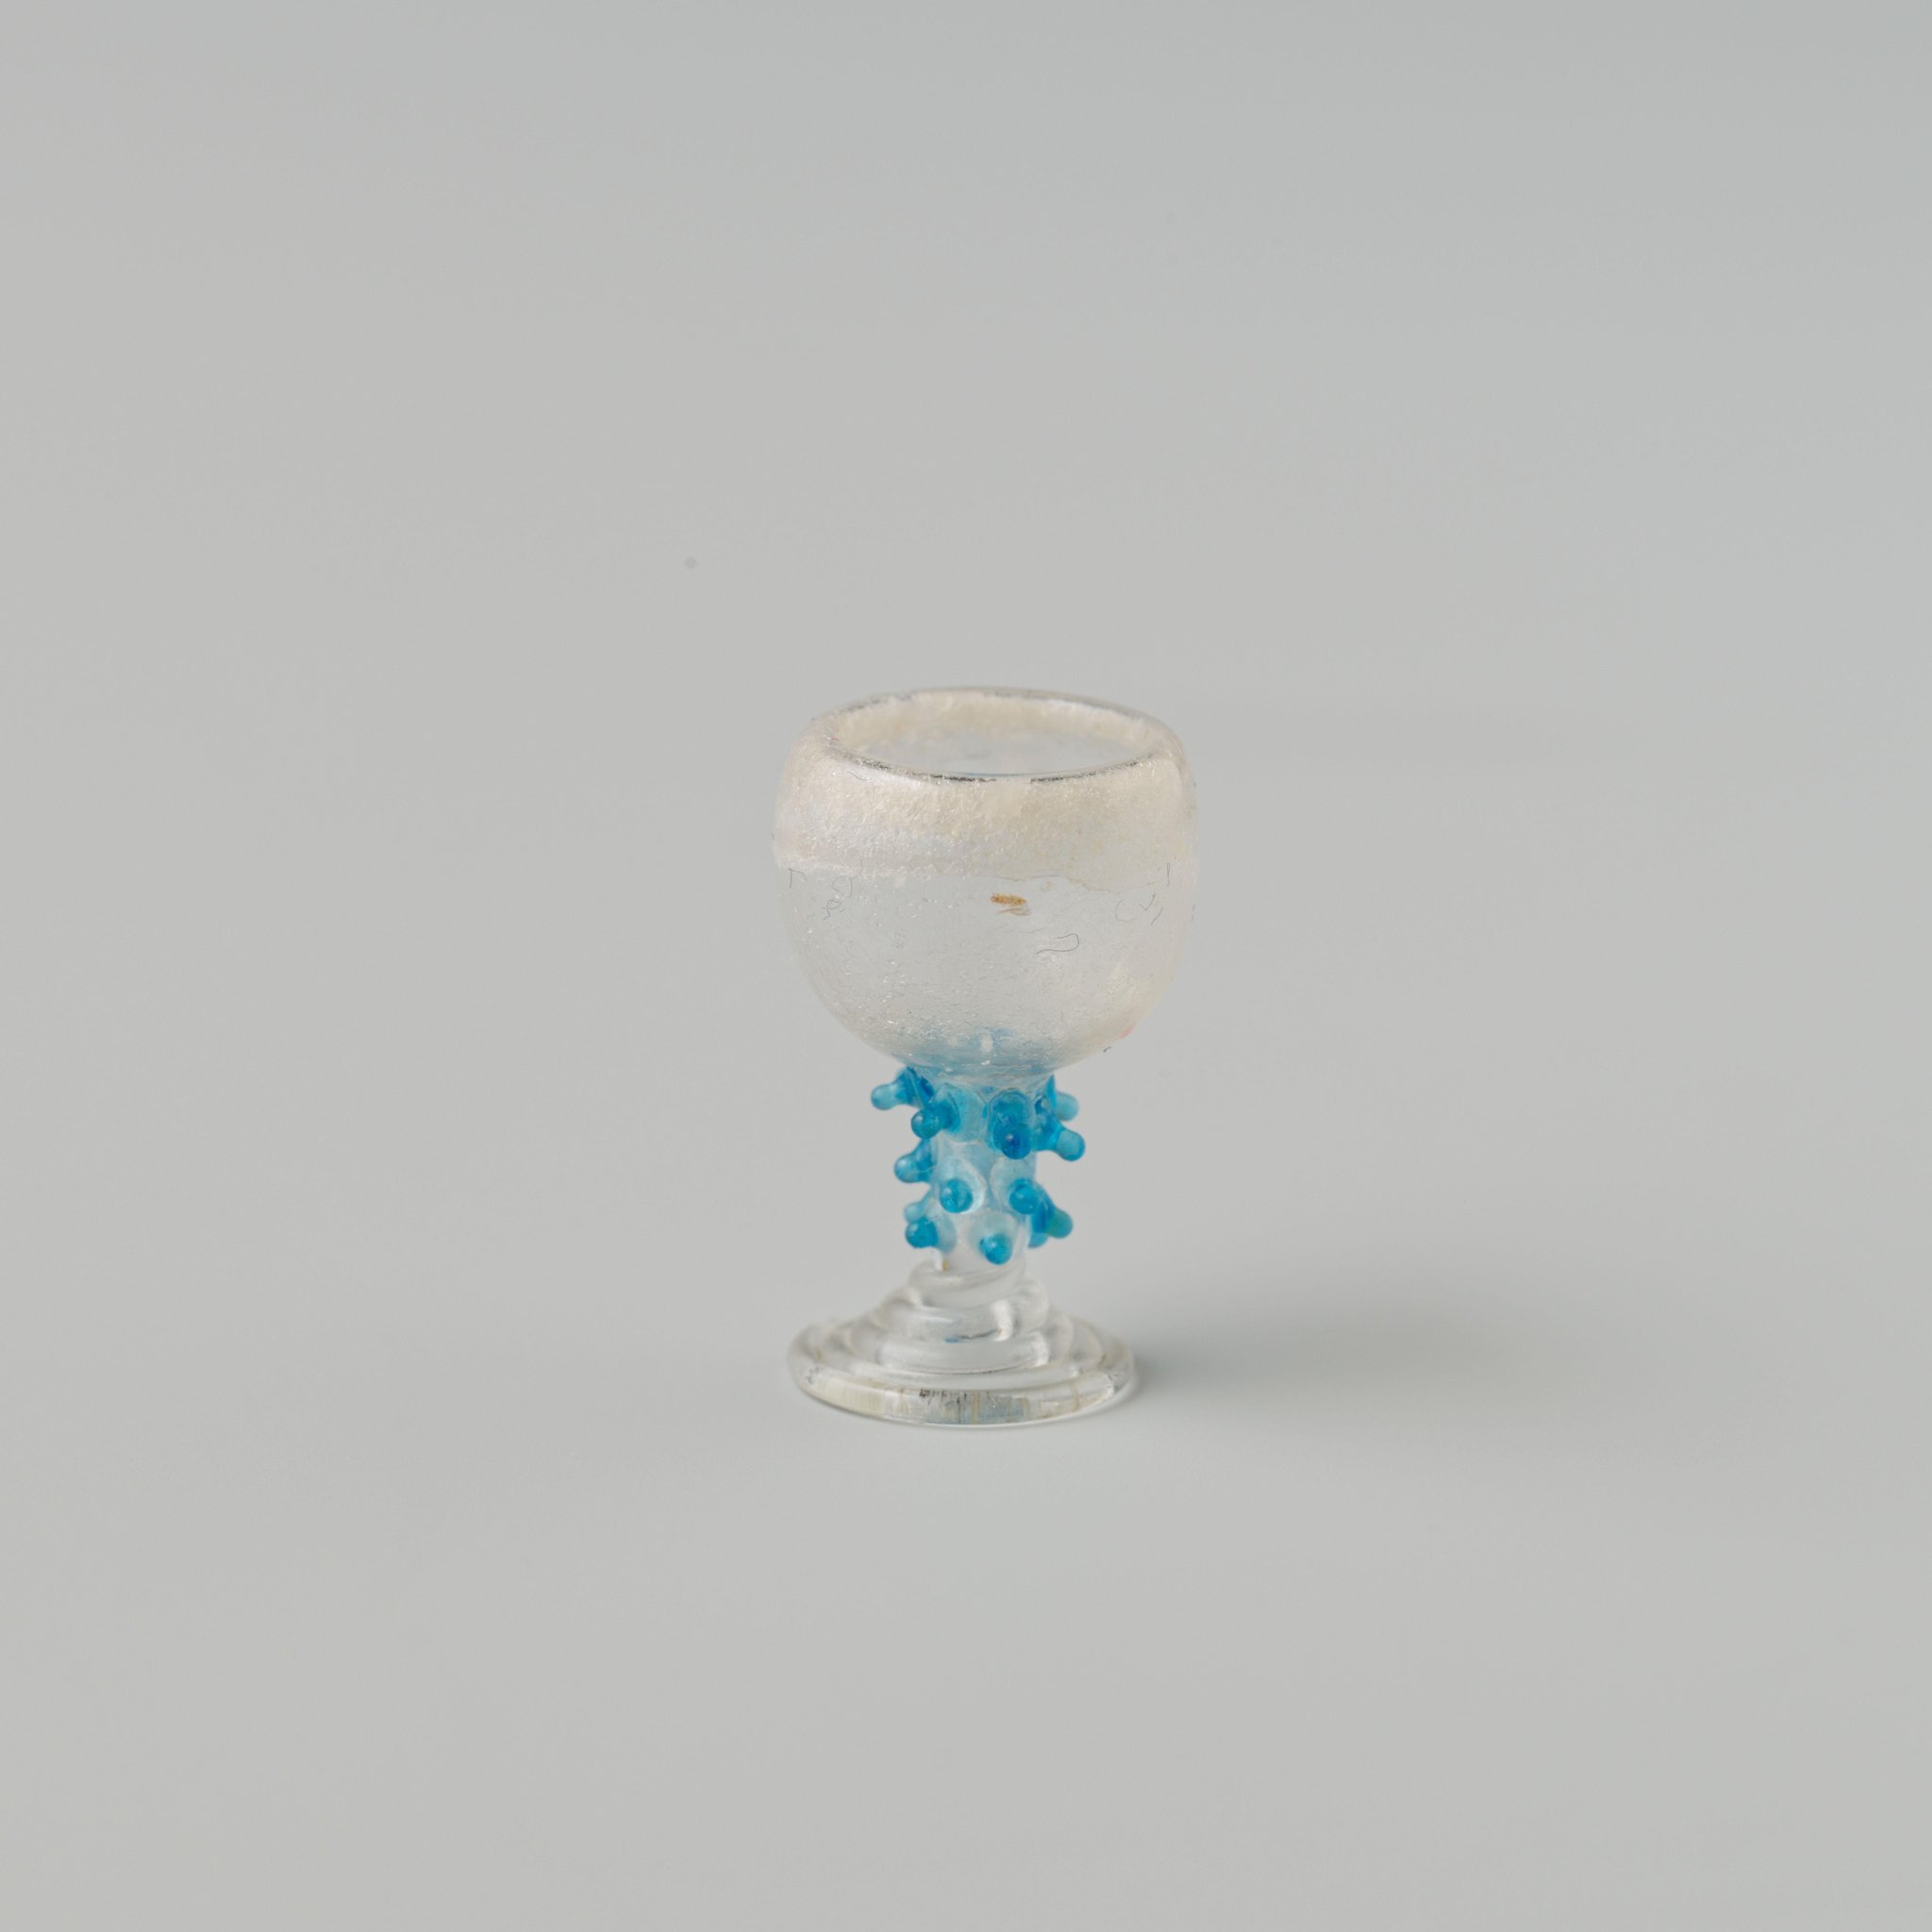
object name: miniature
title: Roemer van helder kleurloos glas met blauwe noppen op de schacht; cuppa dubbelwandig; voet van gespannen glasdraad.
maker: Anonymous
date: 1675-1710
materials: glass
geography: amsterdam